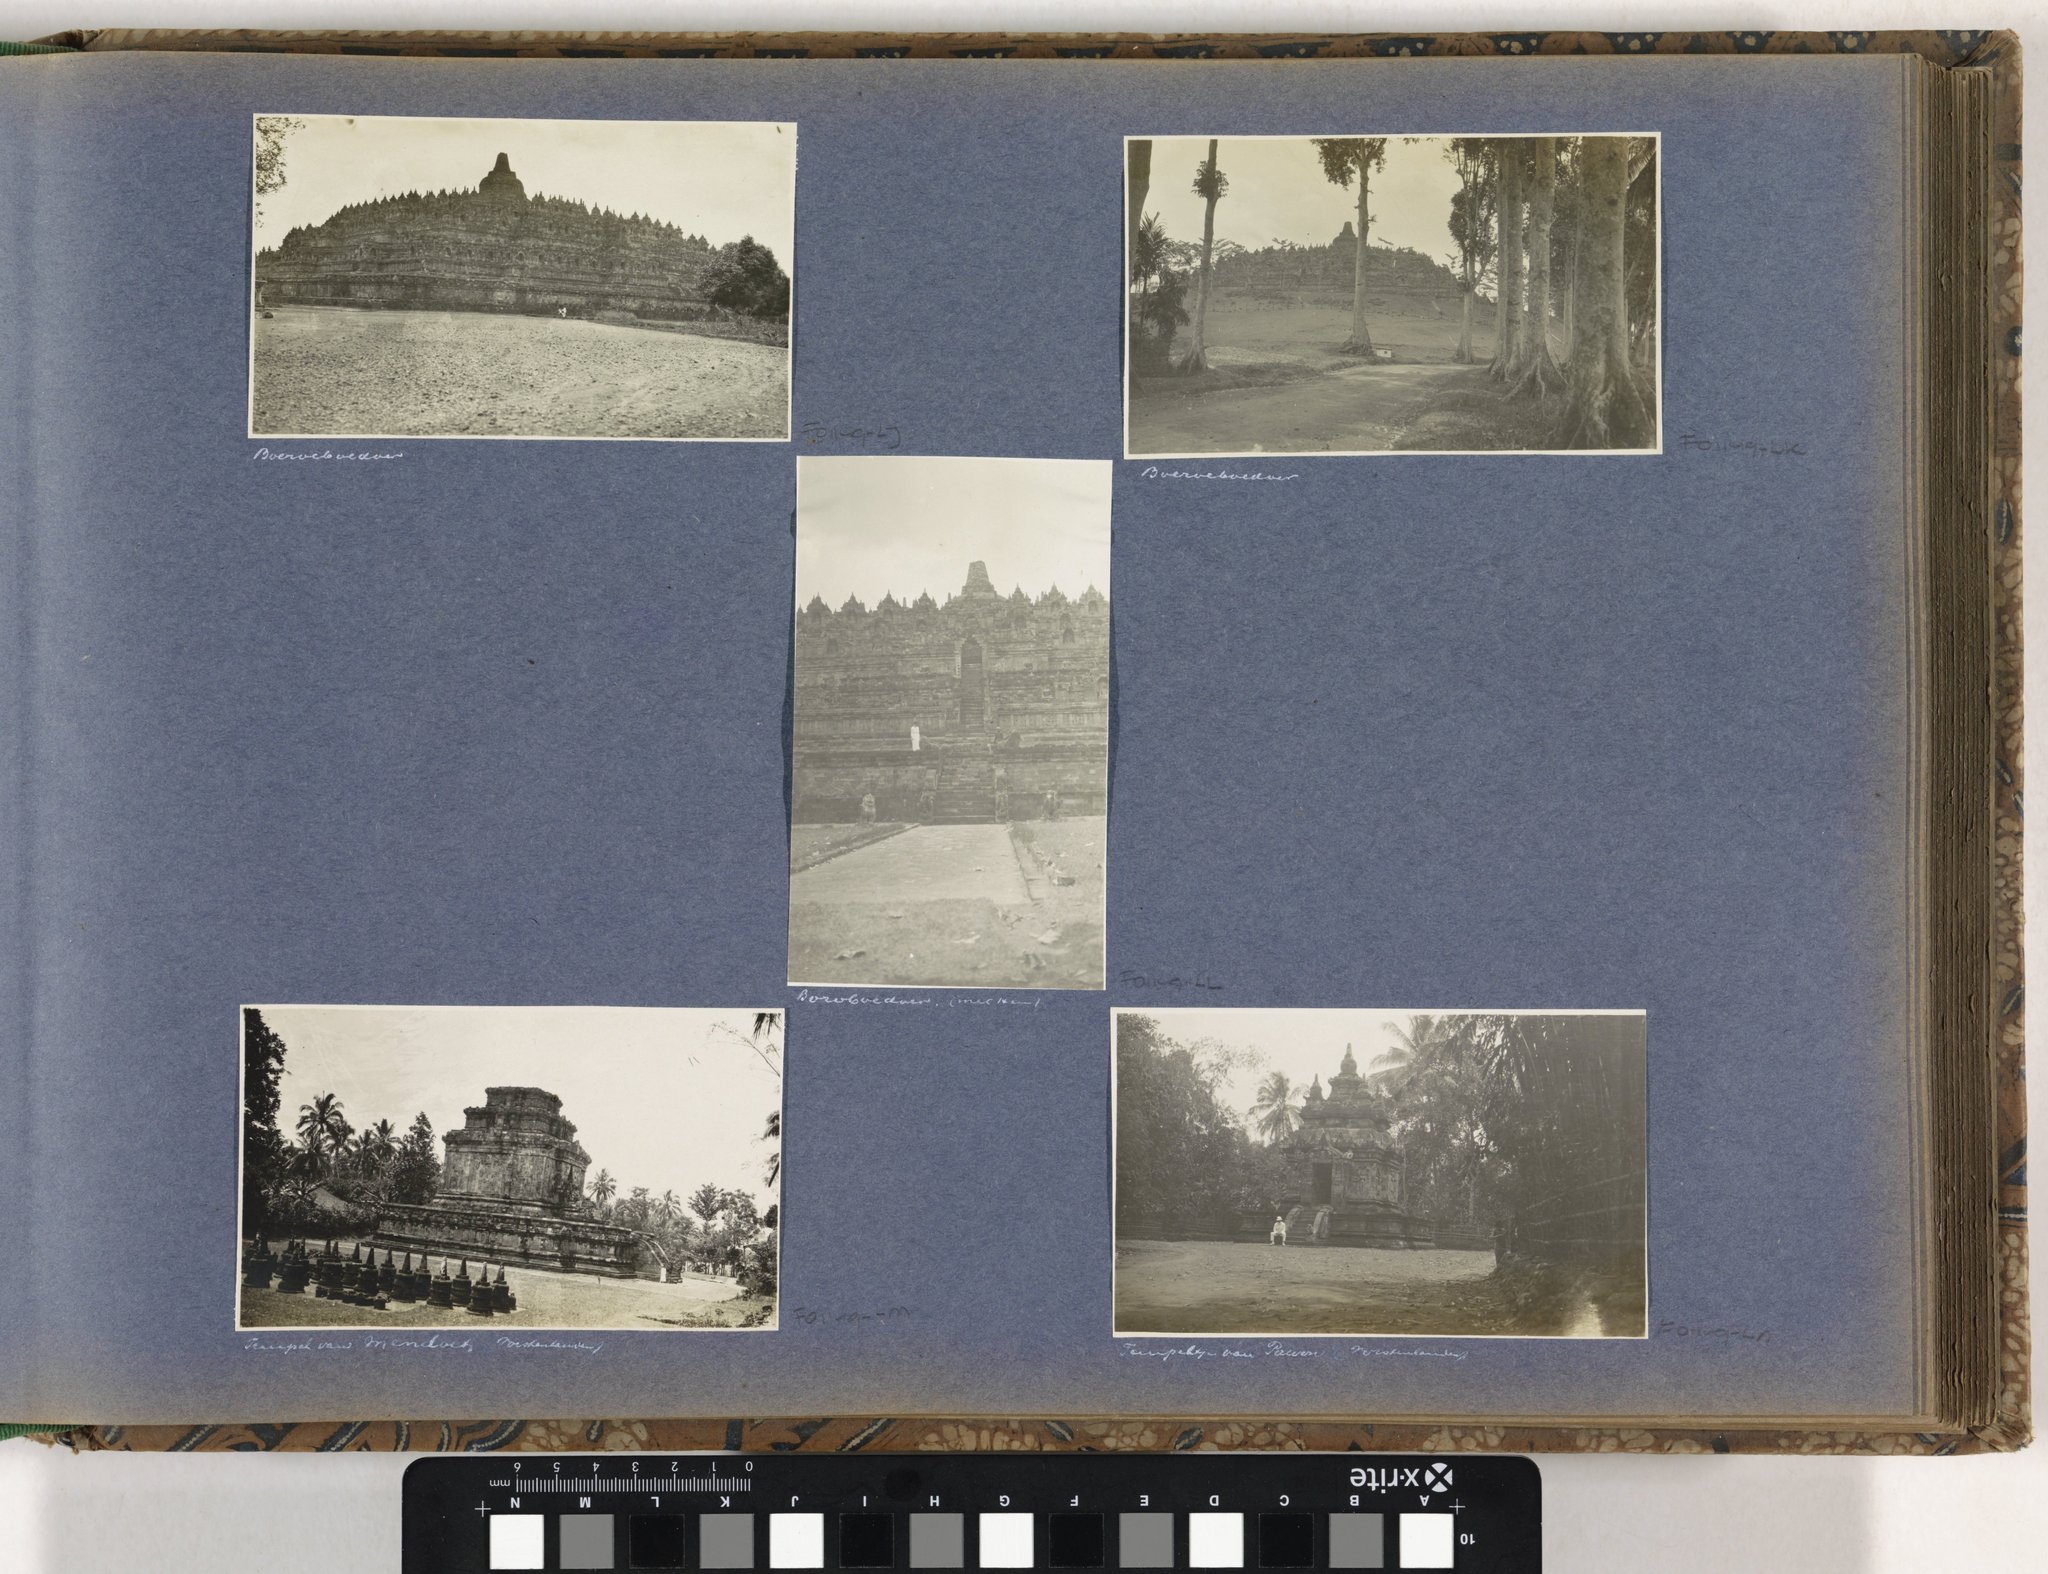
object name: album leaf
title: Gezicht op de Borobudur op Java met op de voorgrond bomen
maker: Anonymous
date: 1900-1920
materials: paper, photographic support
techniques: gelatin silver print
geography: borobudur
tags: temple, shrine ~ hinduism, buddhism, jainism, trees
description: Onderdeel van reisalbum met foto's van bedrijvigheid en bezienswaardigheden op Sumatra en Java en van de reis naar en van Nederlands-Indië.